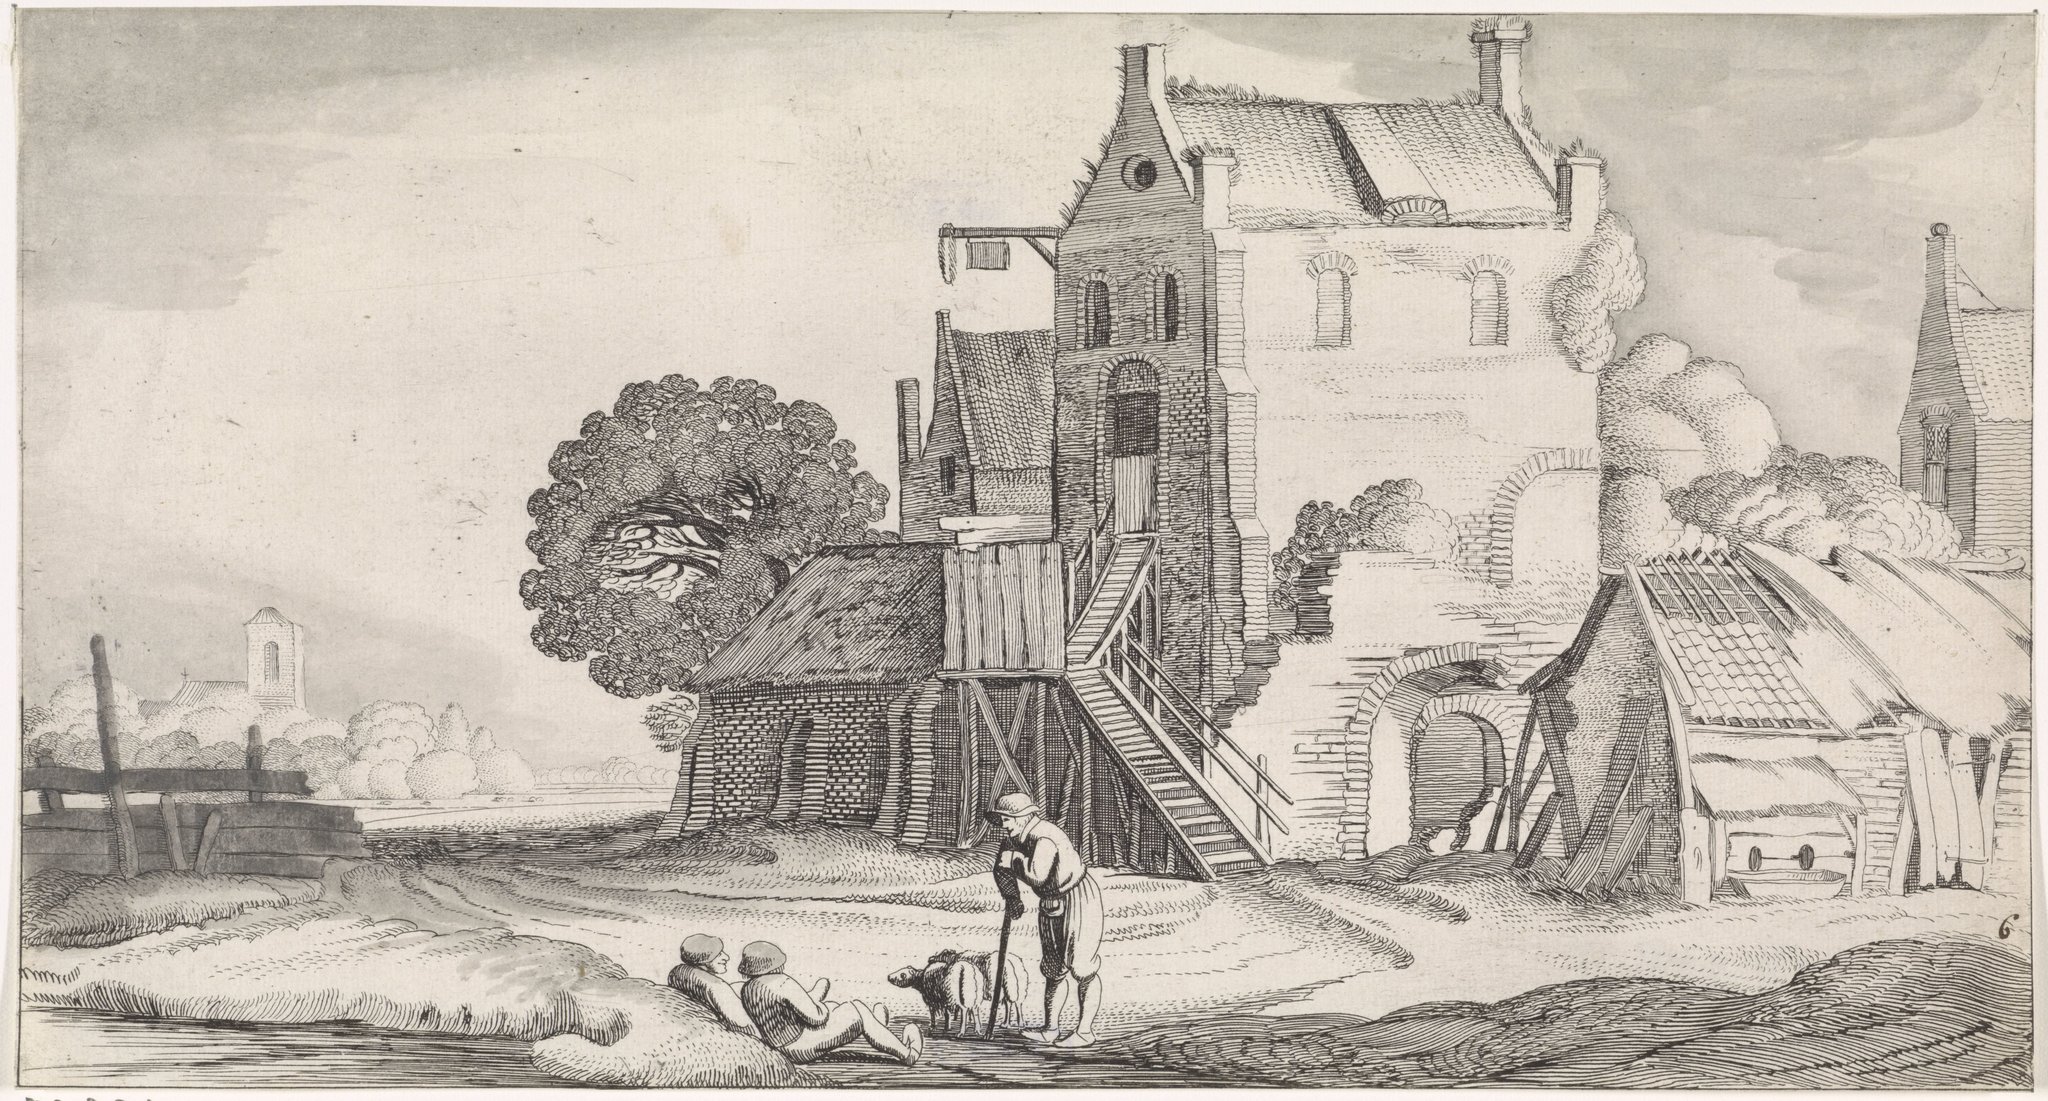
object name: print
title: Drie converserende figuren bij een herberg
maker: jan van de velde (ii)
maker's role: draughtsman, painter, print maker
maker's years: 1593-1641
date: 1639-1641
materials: ink, paper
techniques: brush, etching, pen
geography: northern netherlands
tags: herding, herdsman, herdswoman, shepherd, shepherdess, cowherd, etc., leaning figure, hotel, hostelry, inn, parts of church exterior and annexes: tower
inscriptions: collector's mark: Lugt 1120, collector's mark: Lugt 2228, number: ‘6’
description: Een herder leunend op zijn staf en twee rustende figuren met elkaar in gesprek bij een herberg. Op de achtergrond een kerktoren. Zesde prent van een serie met 36 prenten van landschappen, verdeeld over zes delen.